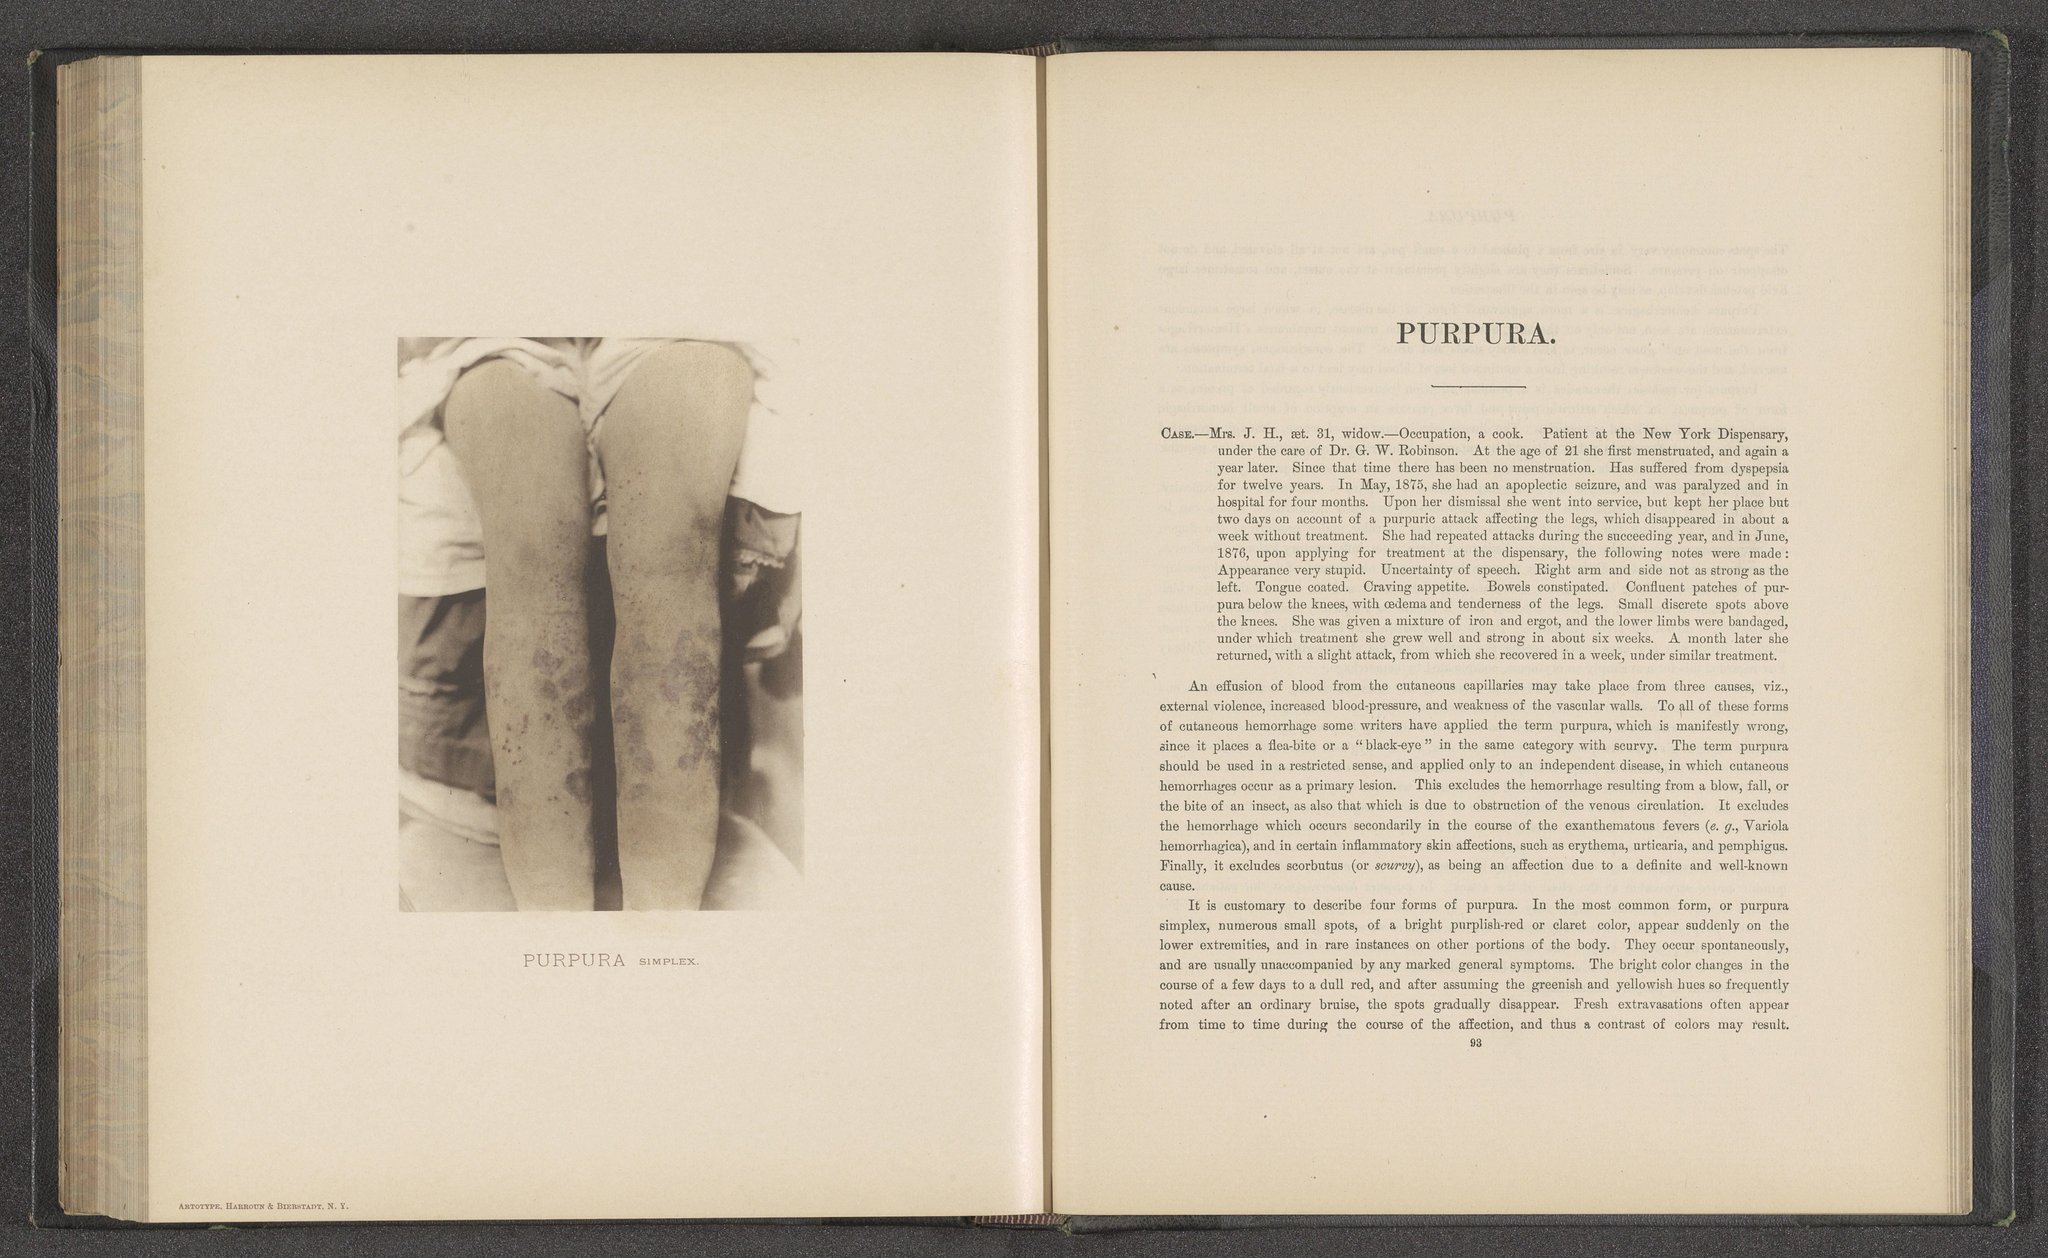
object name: page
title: Patiënt lijdend aan de huidziekte 'purpura simplex'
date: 1870-1881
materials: paper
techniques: photograph, hand coloring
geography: new york city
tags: skin and venereal diseases, legs